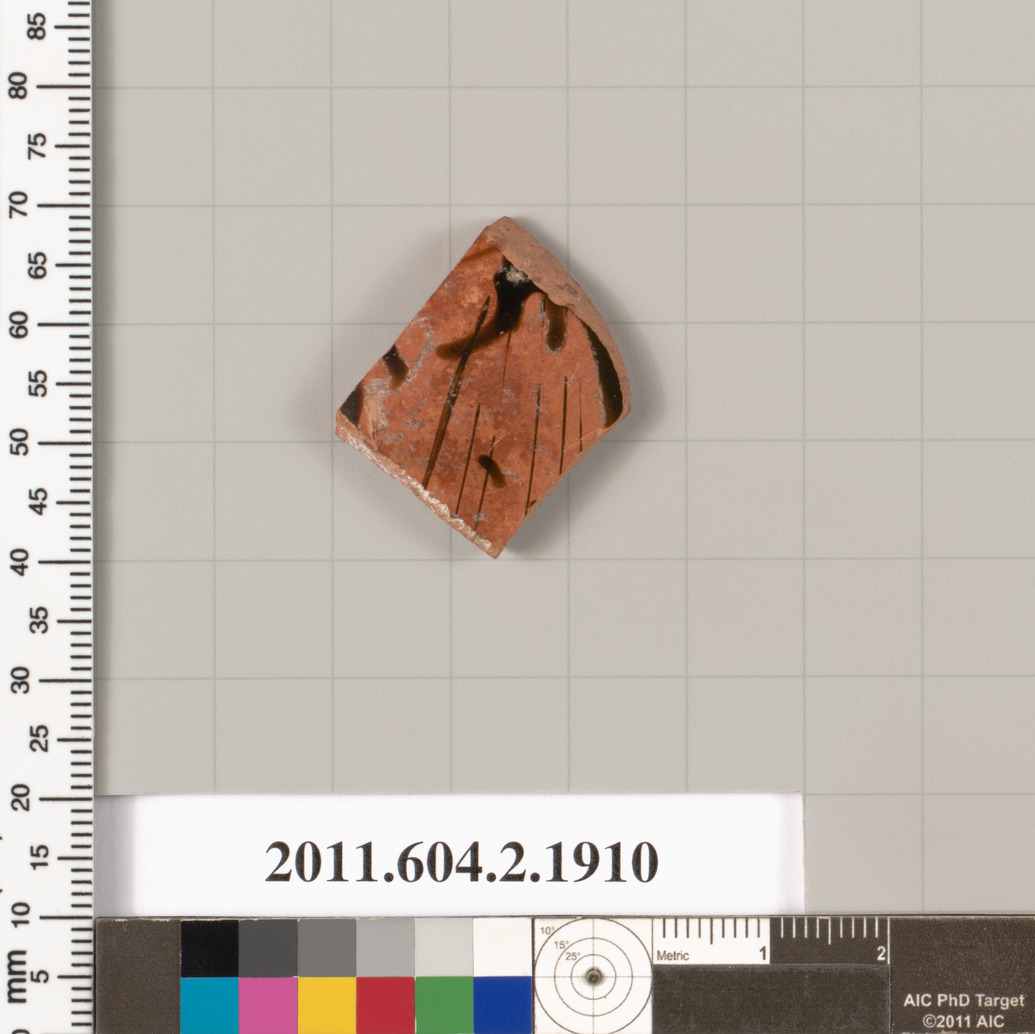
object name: skyphos fragment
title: Terracotta fragment of a skyphos (deep drinking cup)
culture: greek, attic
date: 460-430 BCE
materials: terracotta